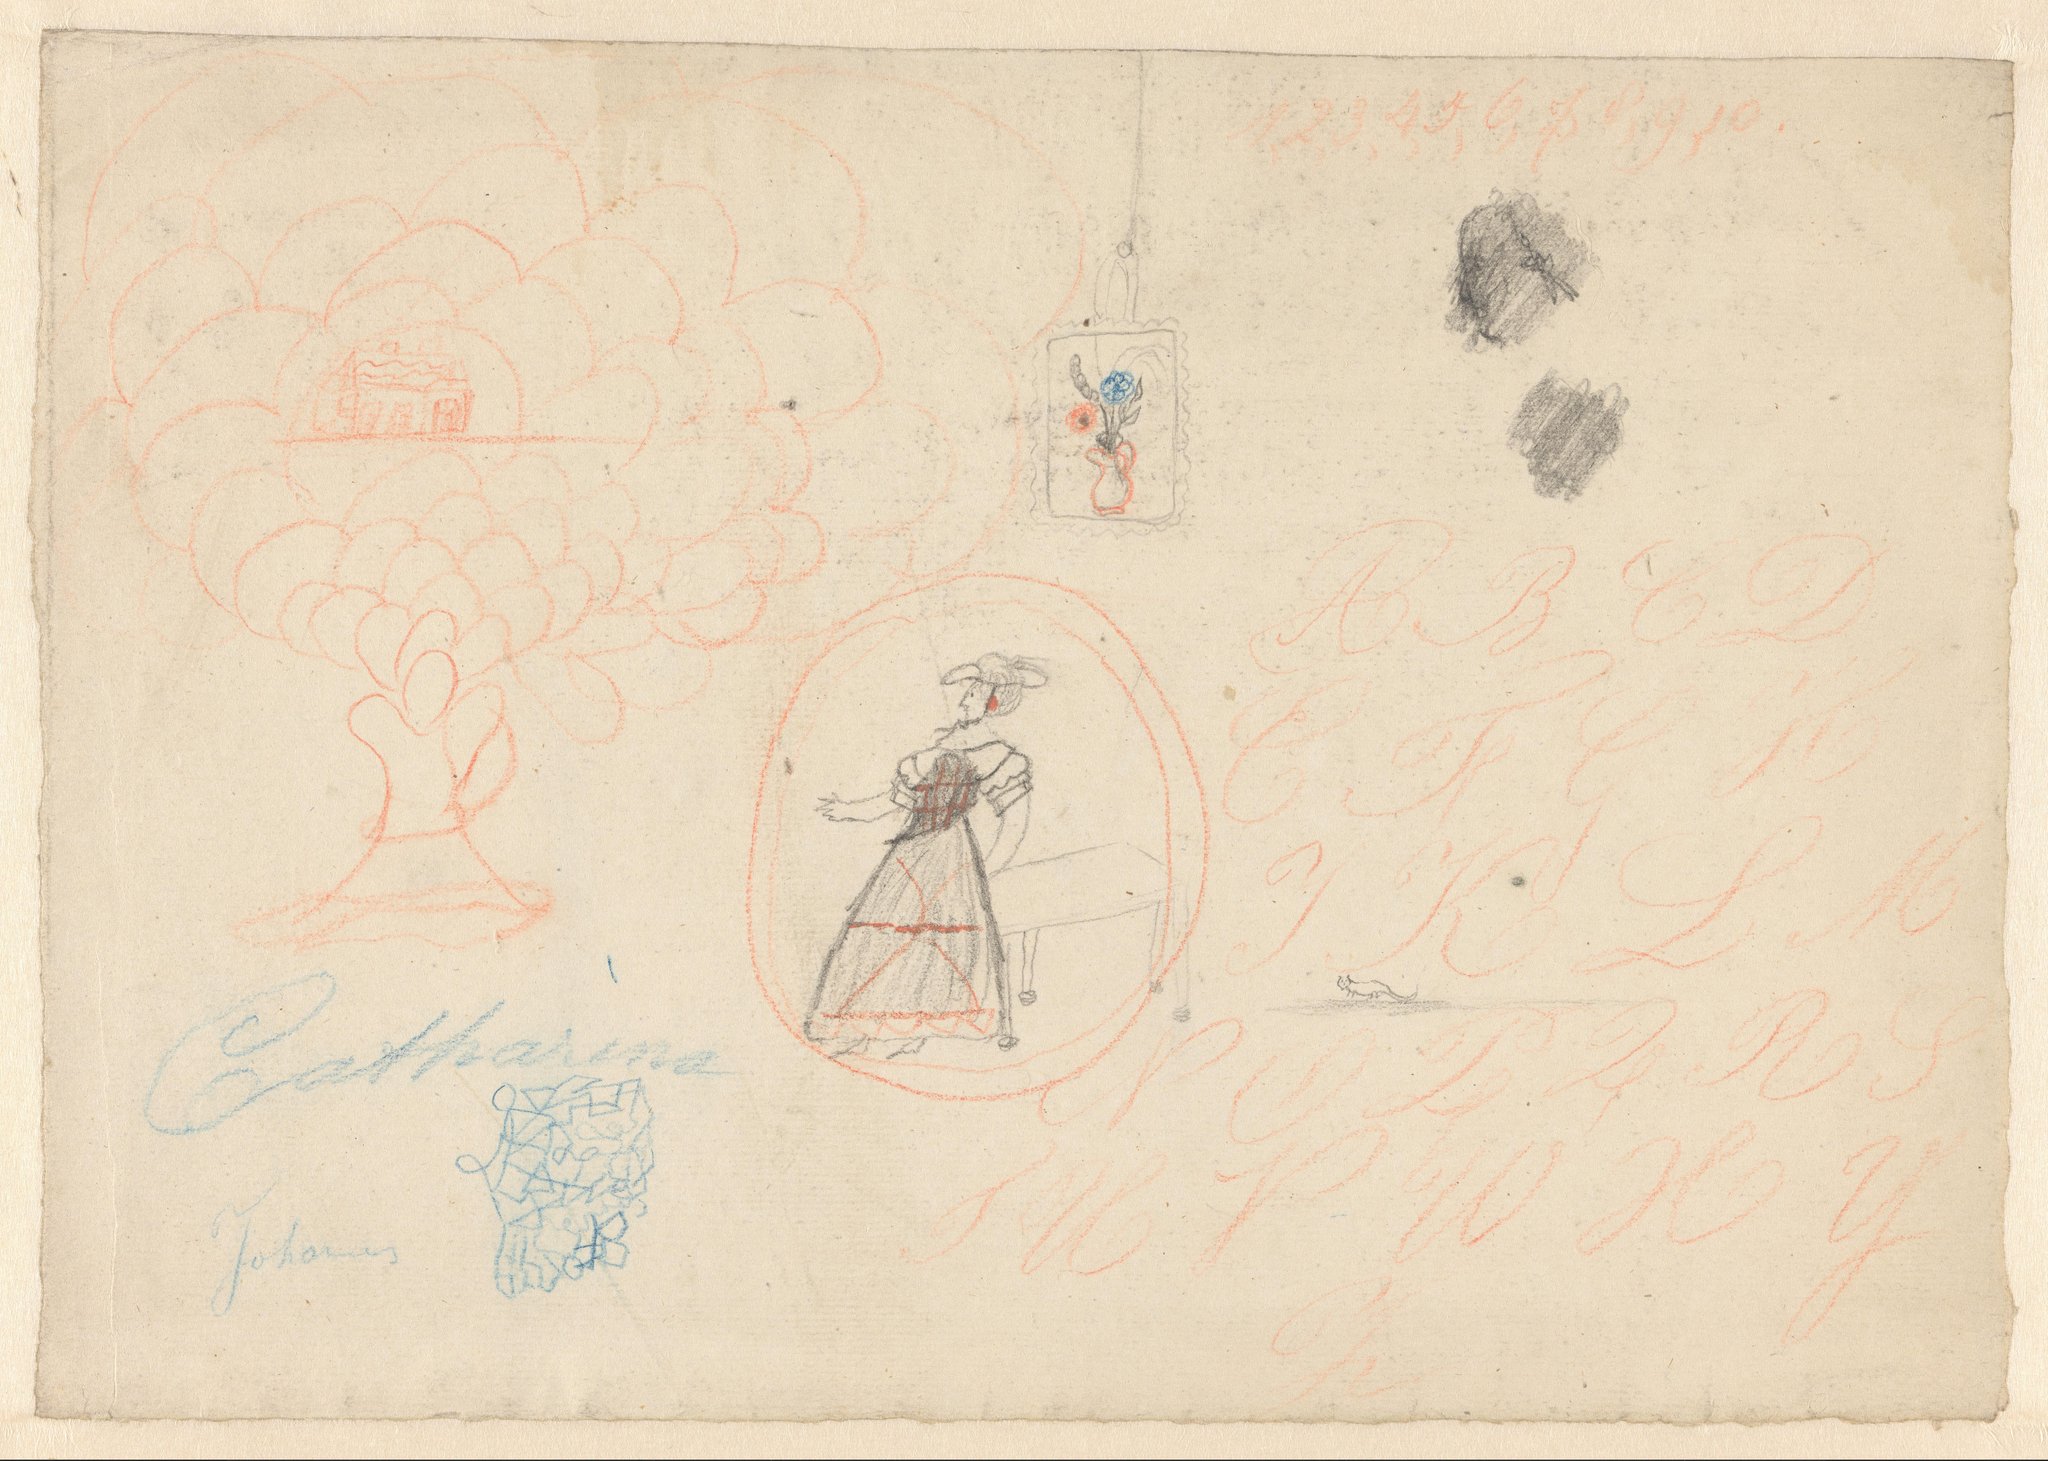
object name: drawing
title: Kindertekening en schrijfoefening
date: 1855-1860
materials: paper, pencil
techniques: writing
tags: adult woman, flowers in a vase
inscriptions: inscription: ‘Catharina / Johannes’